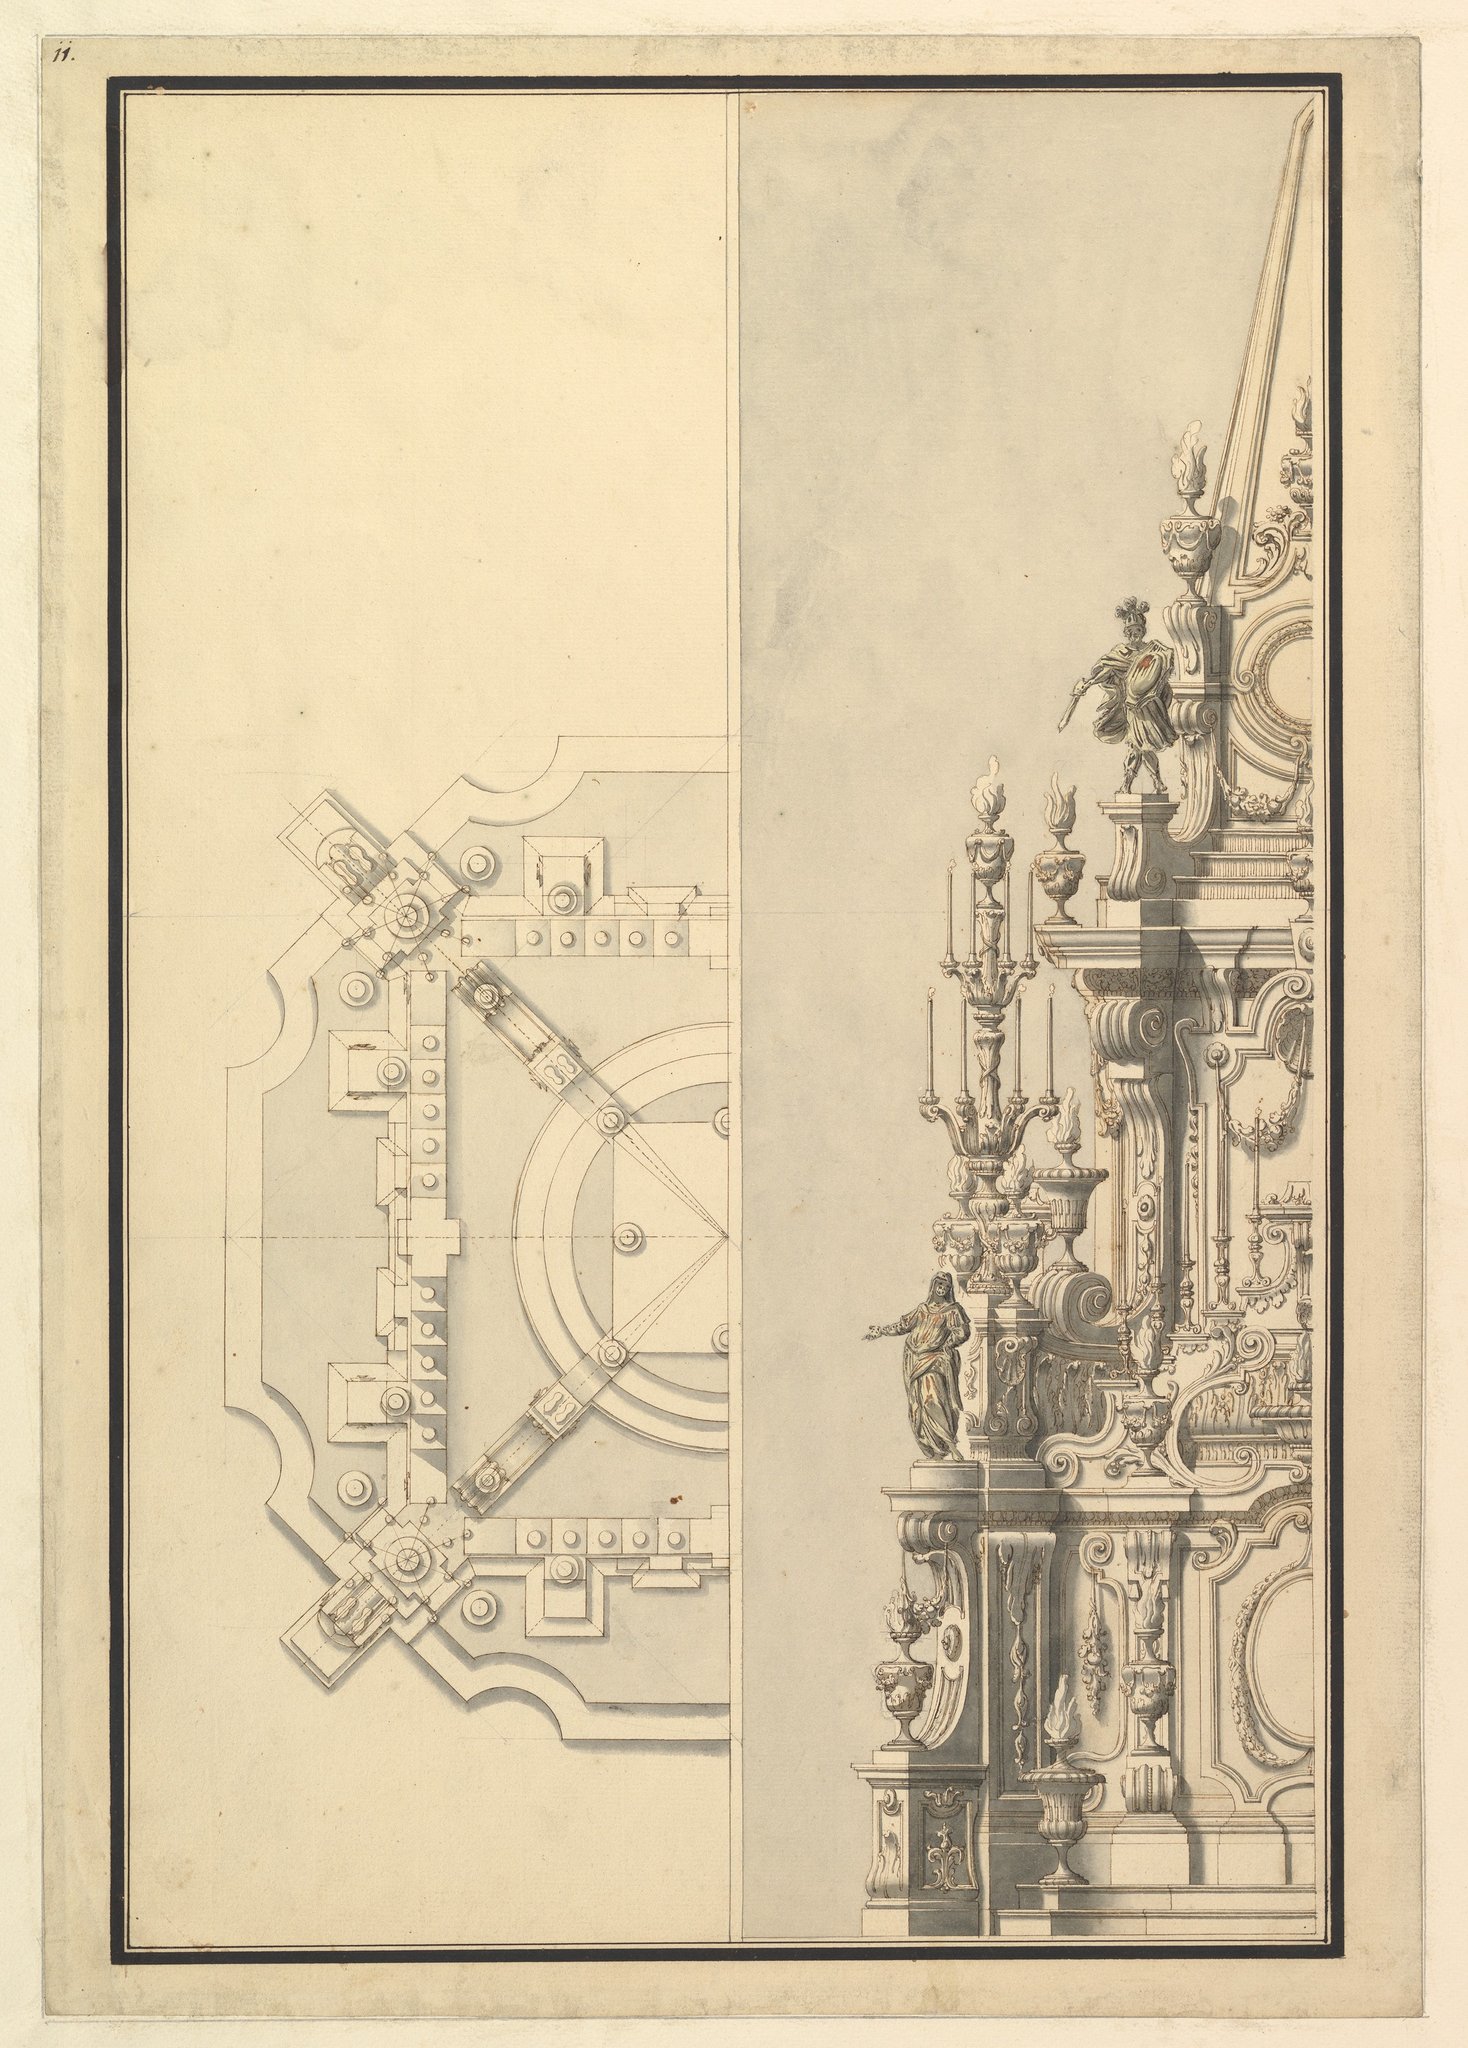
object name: drawing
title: Half Plan and Half Elevation for a Catafalque for Margarita Louisa, Gran Duchess of Tuscany (d. 1721)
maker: giuseppe galli bibiena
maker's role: artist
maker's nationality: italian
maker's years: 1696-1756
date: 1721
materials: ink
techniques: pen, wash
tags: architecture